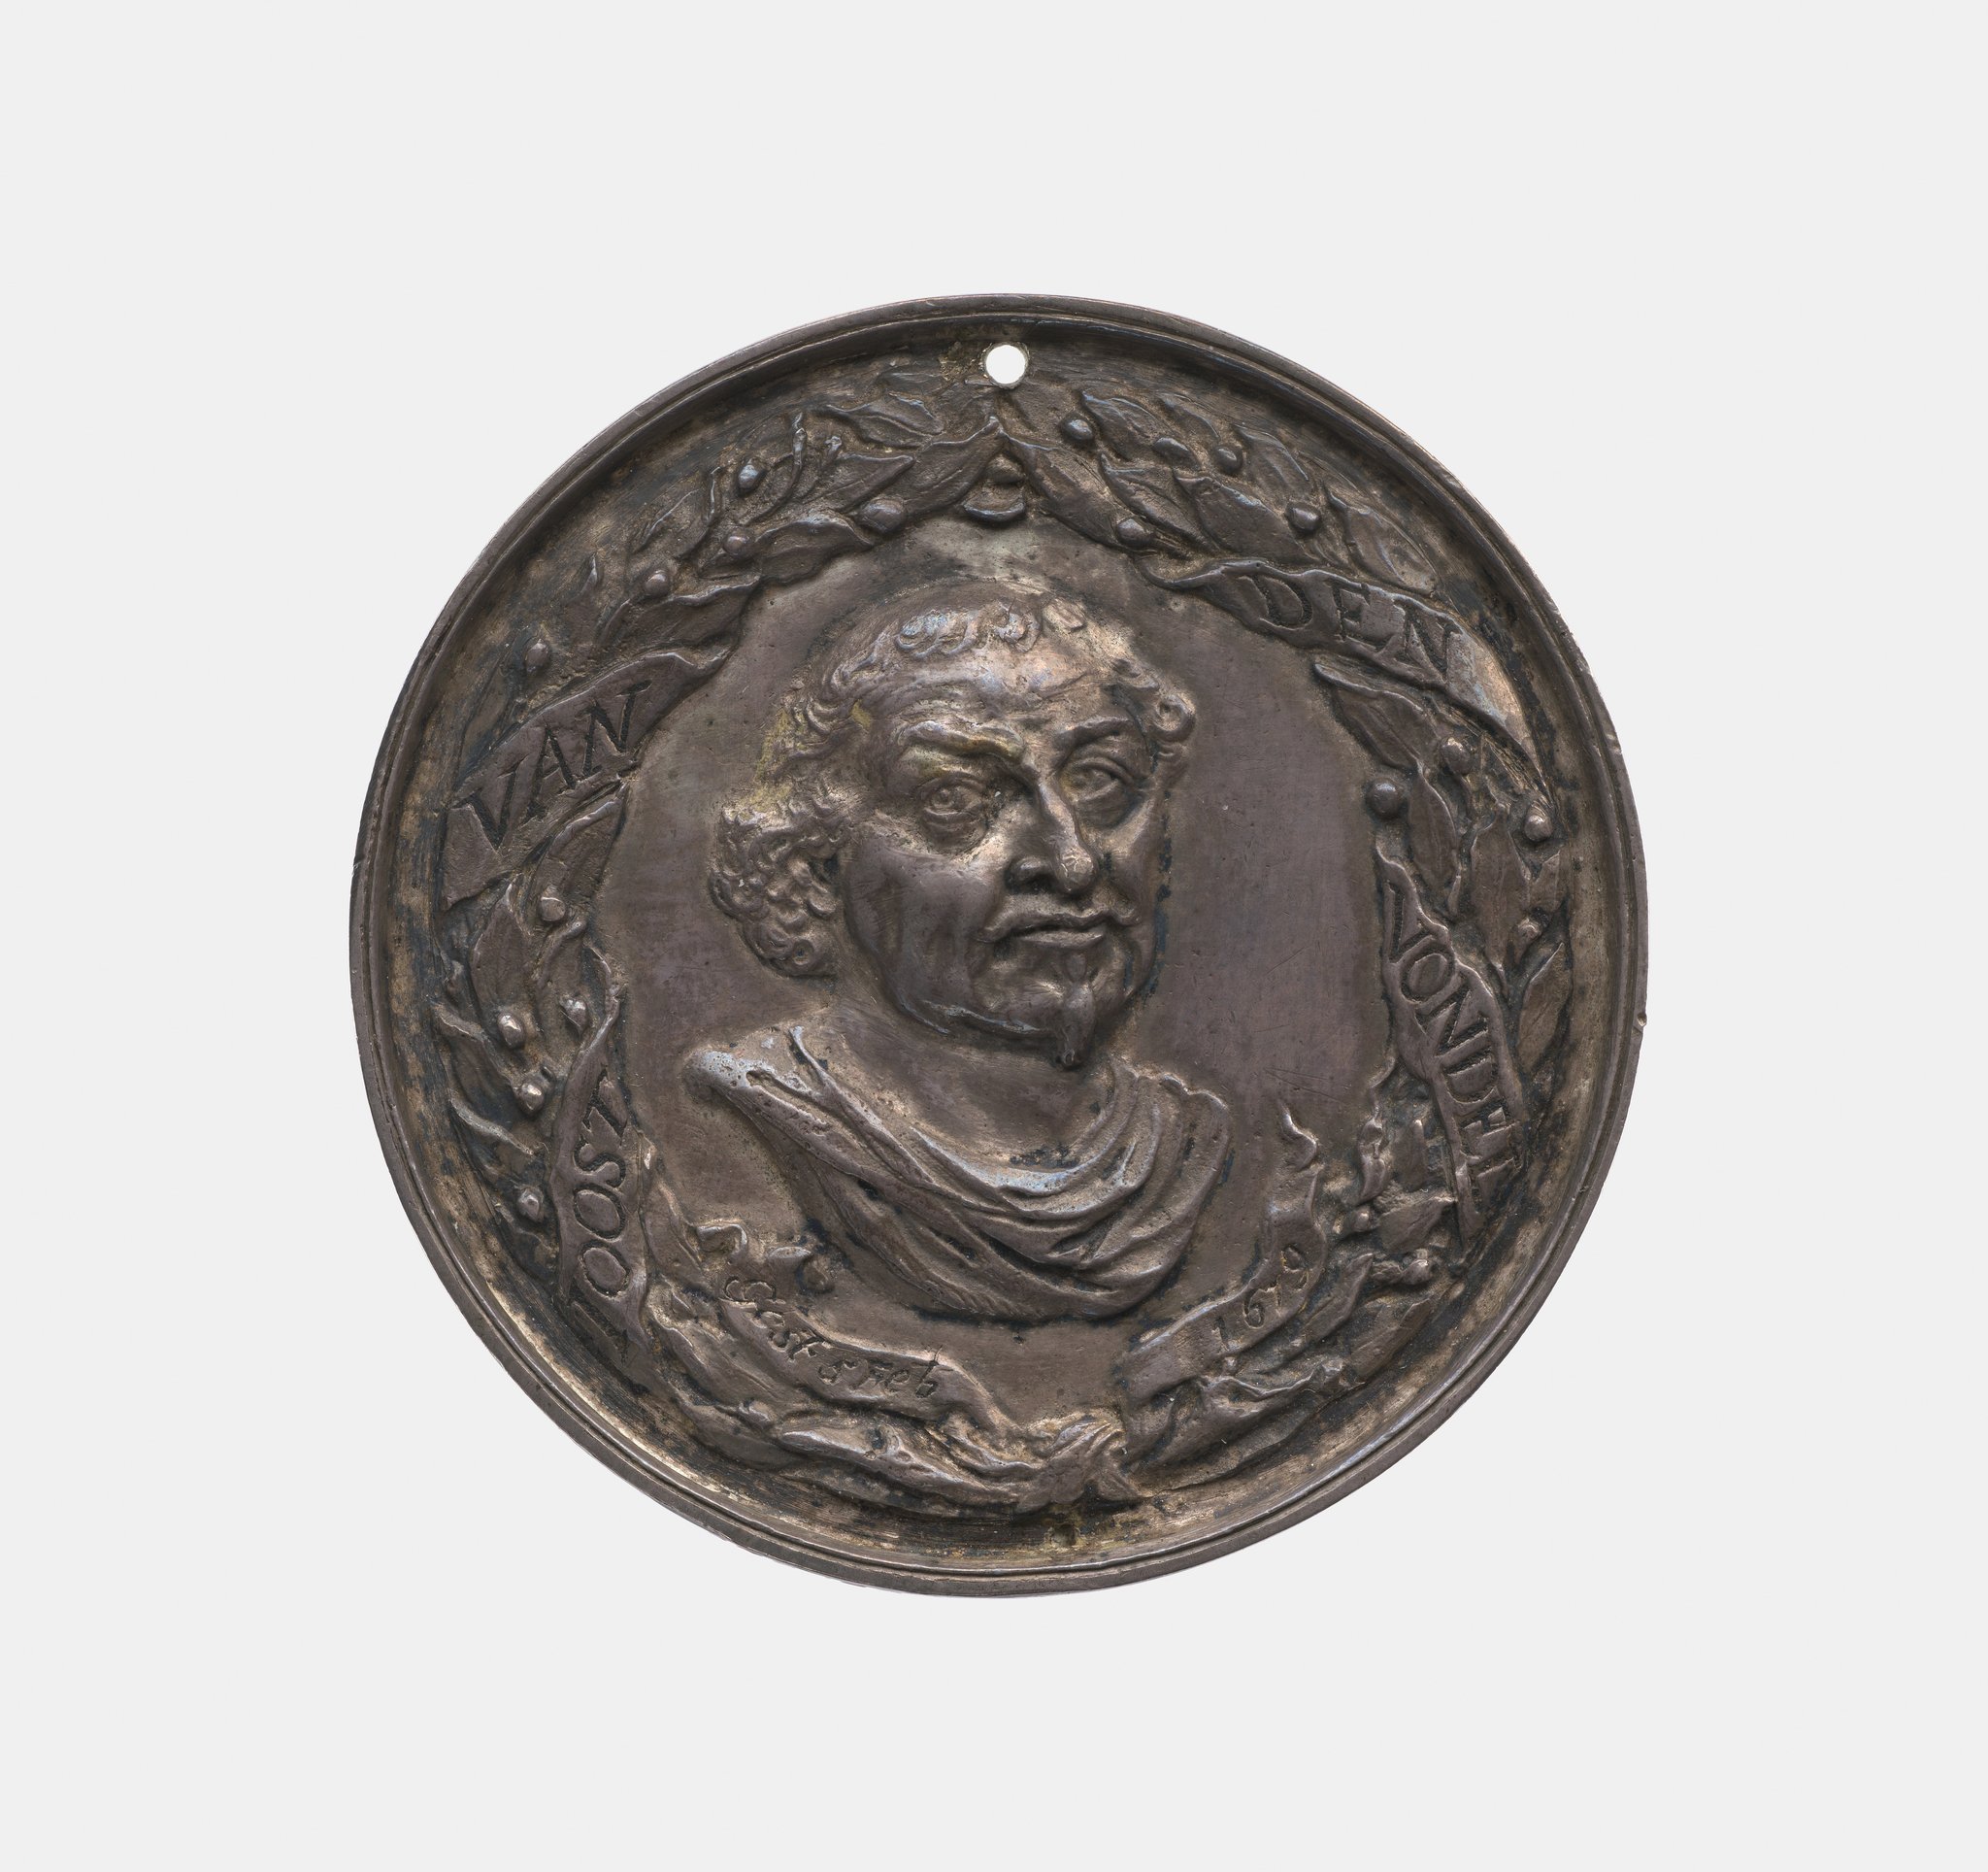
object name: medal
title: Joost van den Vondel 1587-1679, Dutch poet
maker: jan filius lutma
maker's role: artist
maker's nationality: dutch, amsterdam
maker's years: 1605-1685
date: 1679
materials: silver